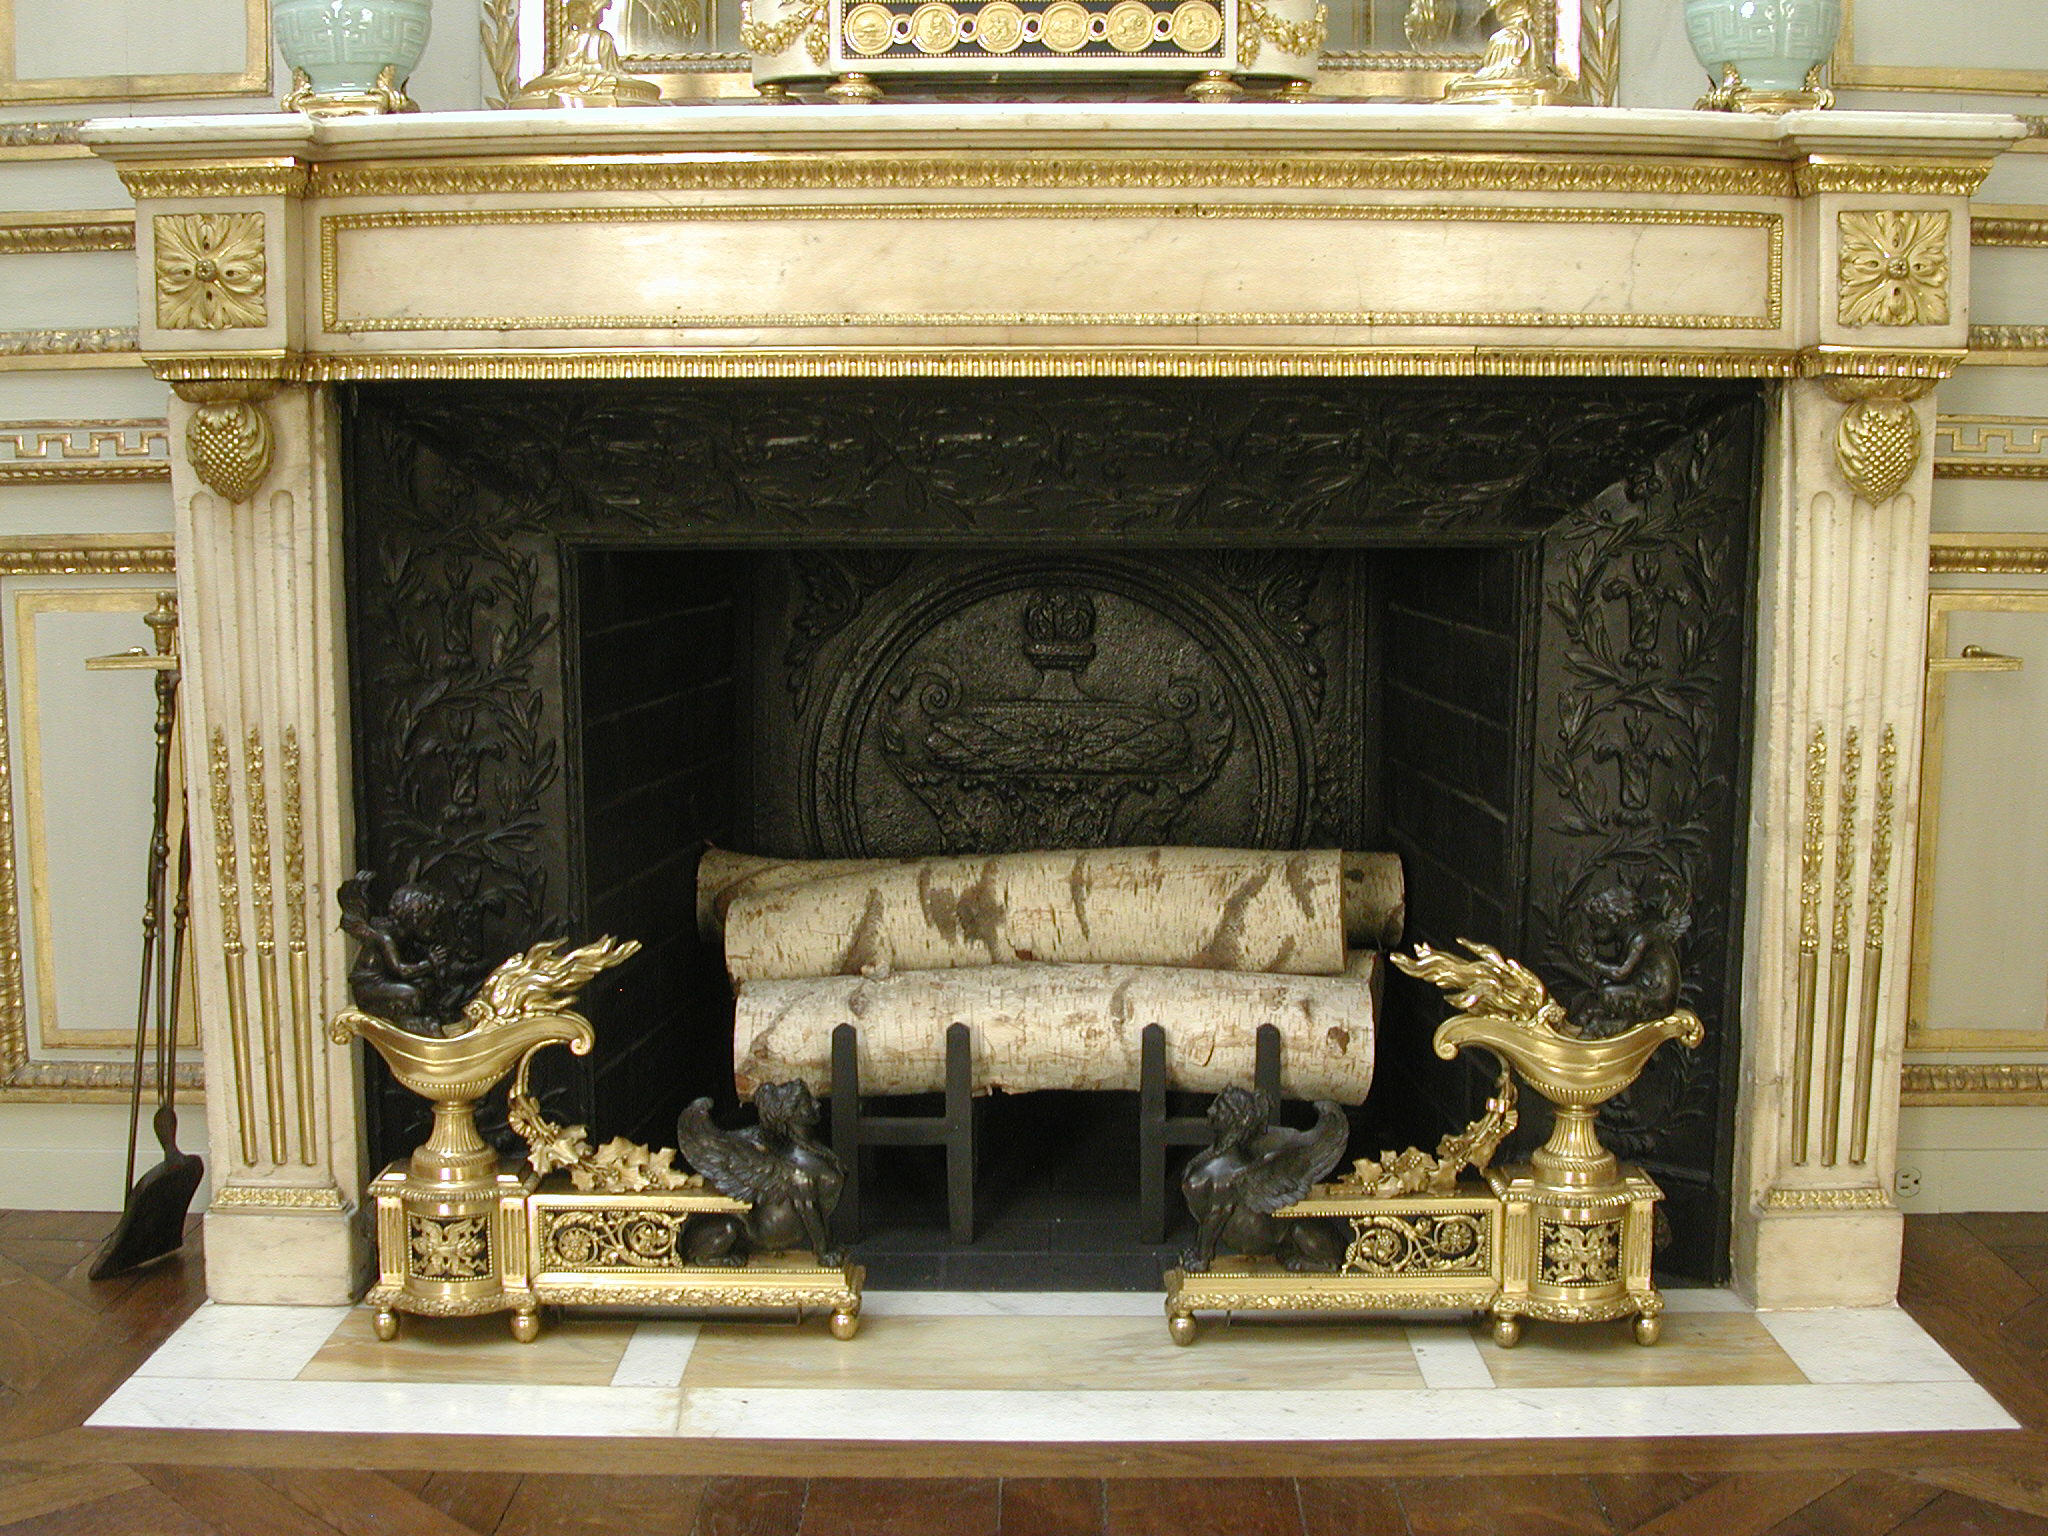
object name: chimneypiece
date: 1775-1785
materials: gilt bronze, marble